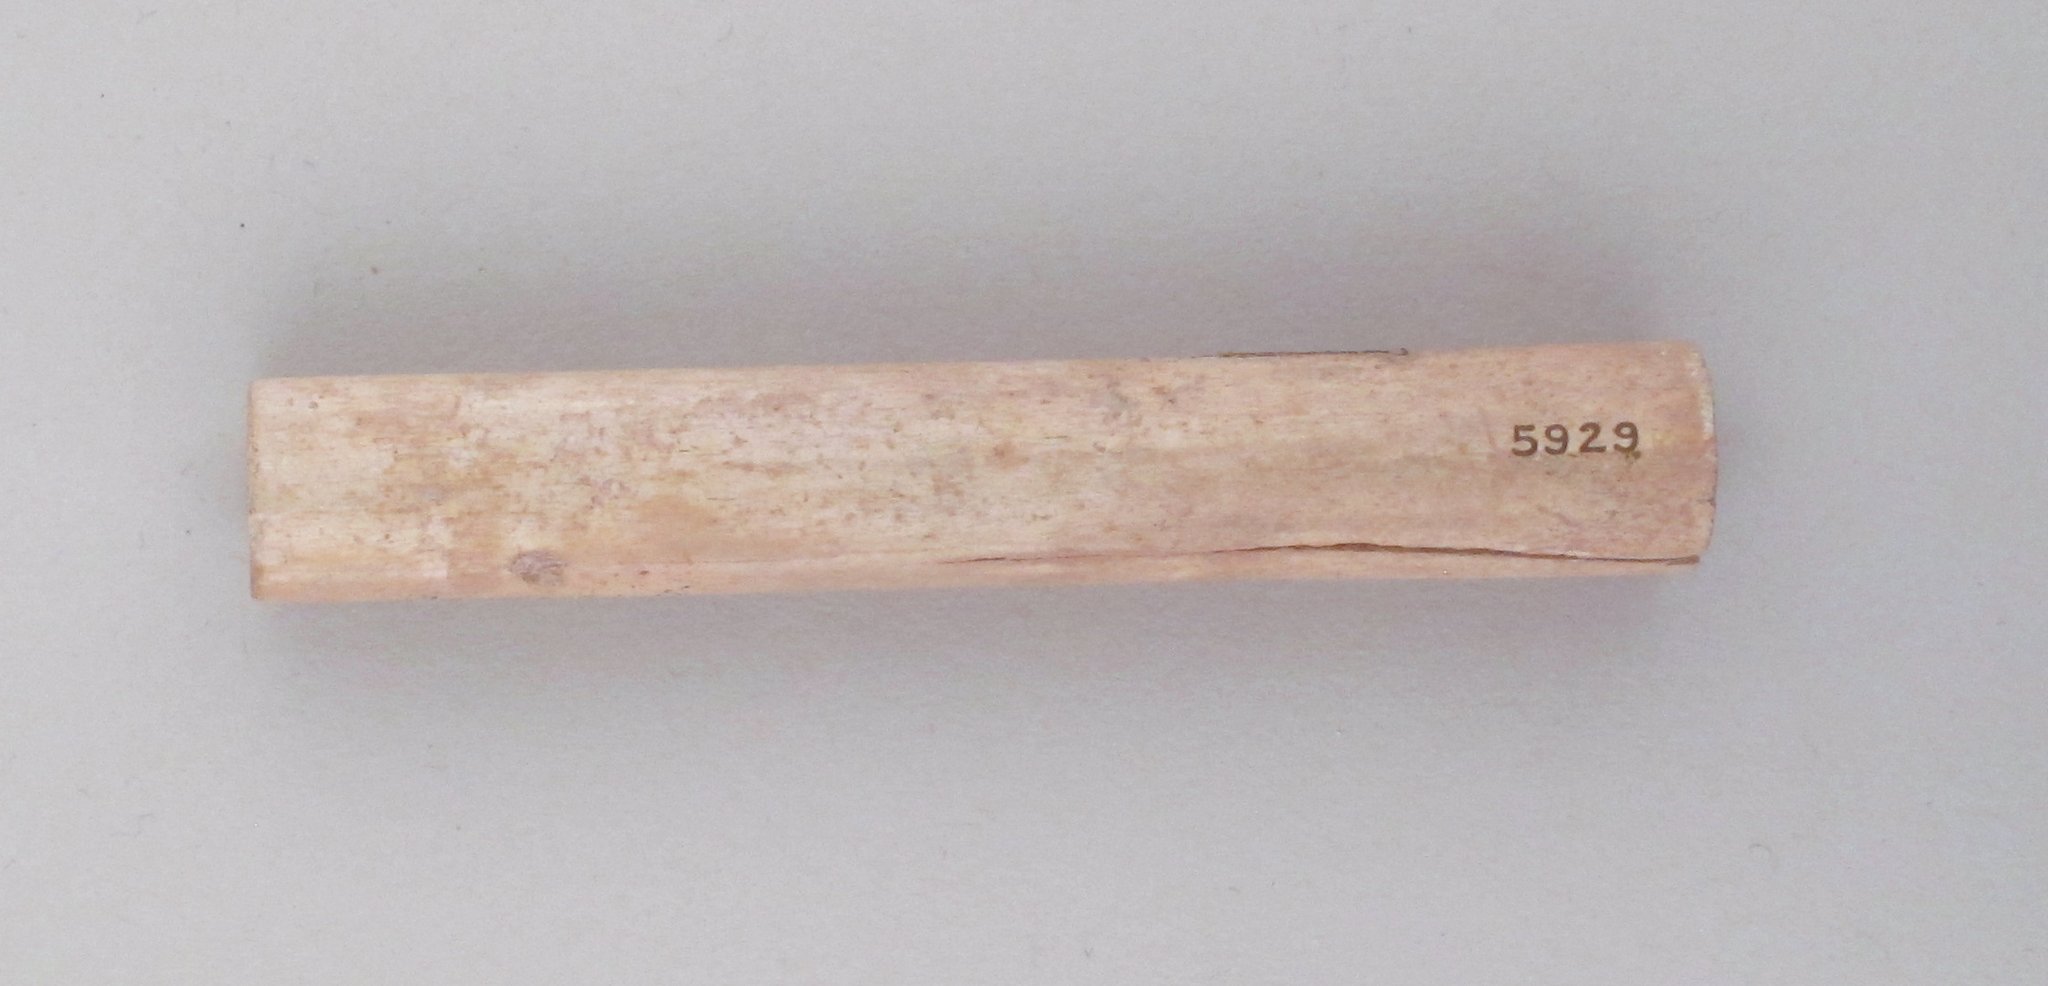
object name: toilet box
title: Bone toilet box or handle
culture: cypriot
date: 3900 BCE-100 CE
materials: bone